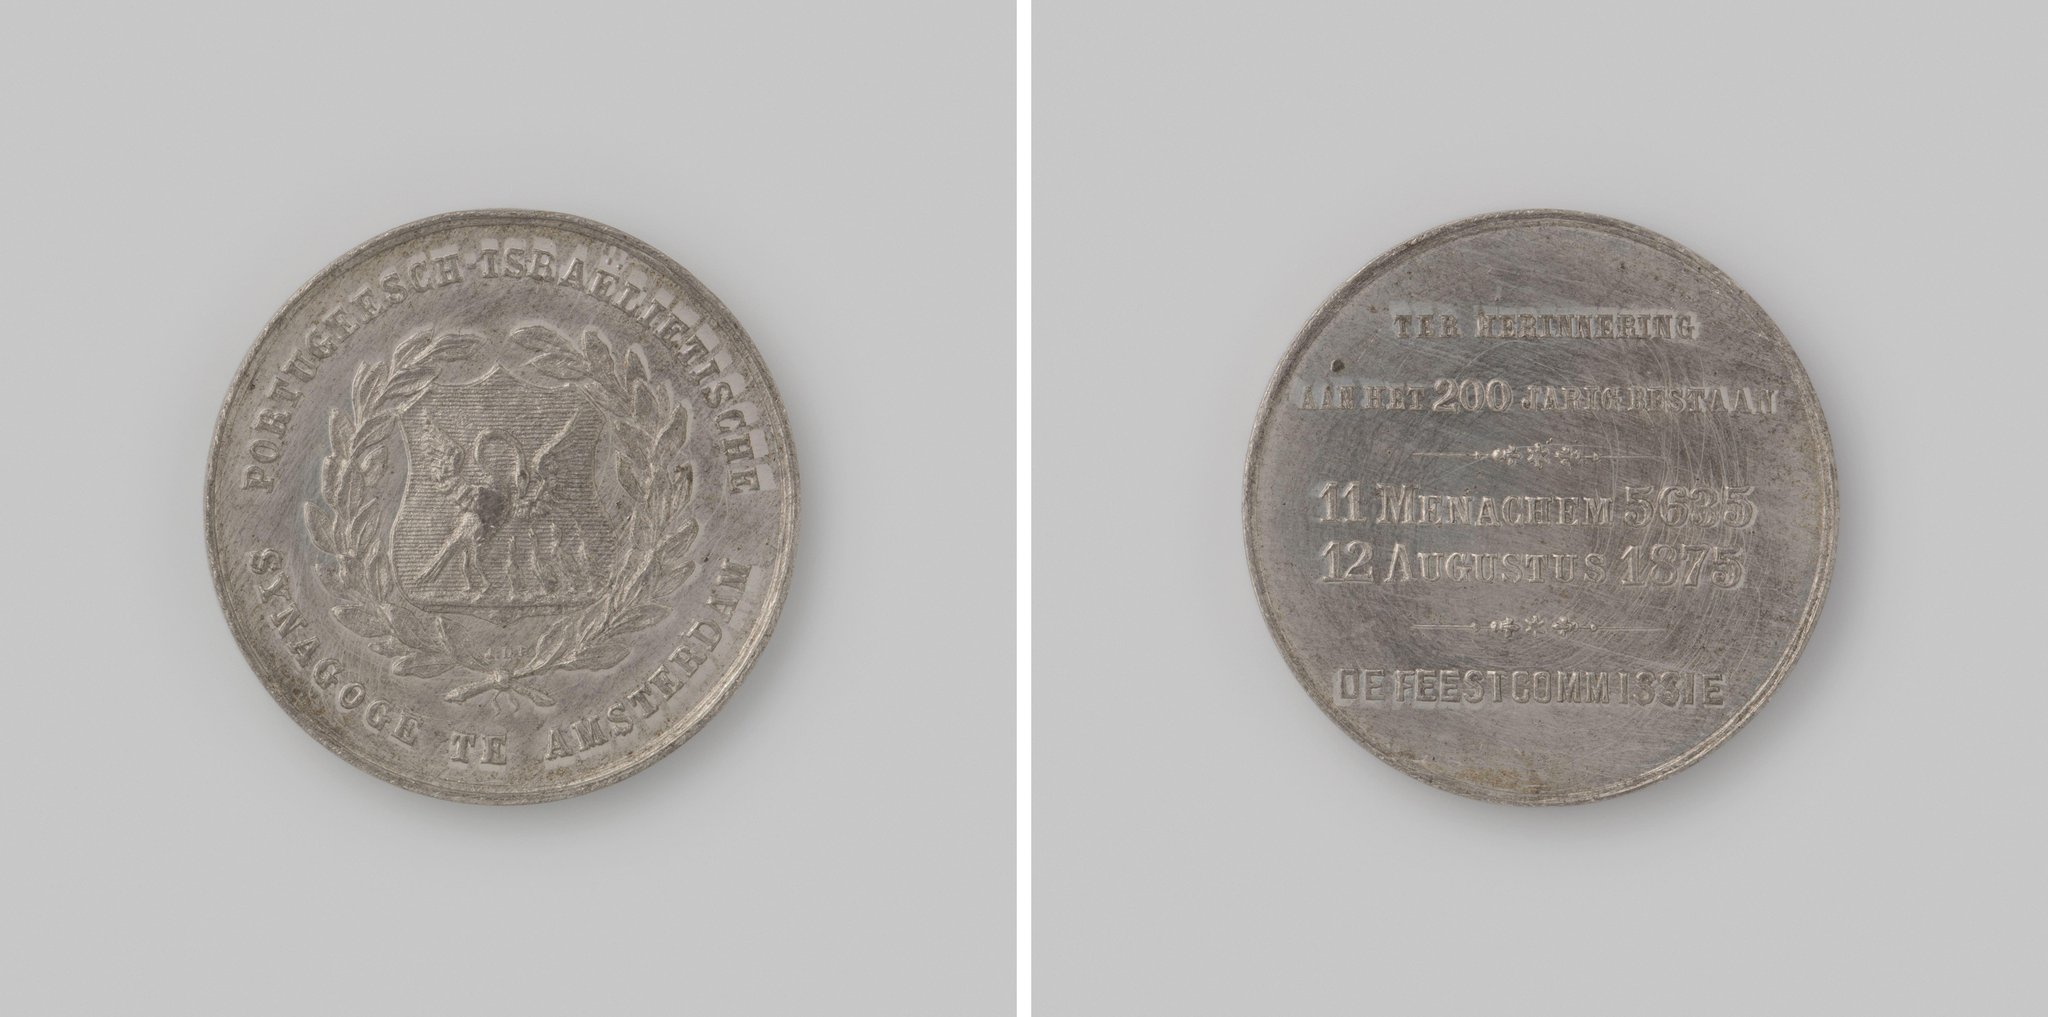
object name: history medal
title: Tweehonderdjarig bestaan van de Portugeesch-Israëlietische Synagoge te Amsterdam 1875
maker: jan postmus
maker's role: silversmith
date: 1875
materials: tin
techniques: striking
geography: amsterdam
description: Tinnen penning, op de voorzijde een wapenschild, waarop een pelikaan met jongen, tussen samengebonden lauwertakken, met omschrift, op de keerzijde vijf regels tekst.